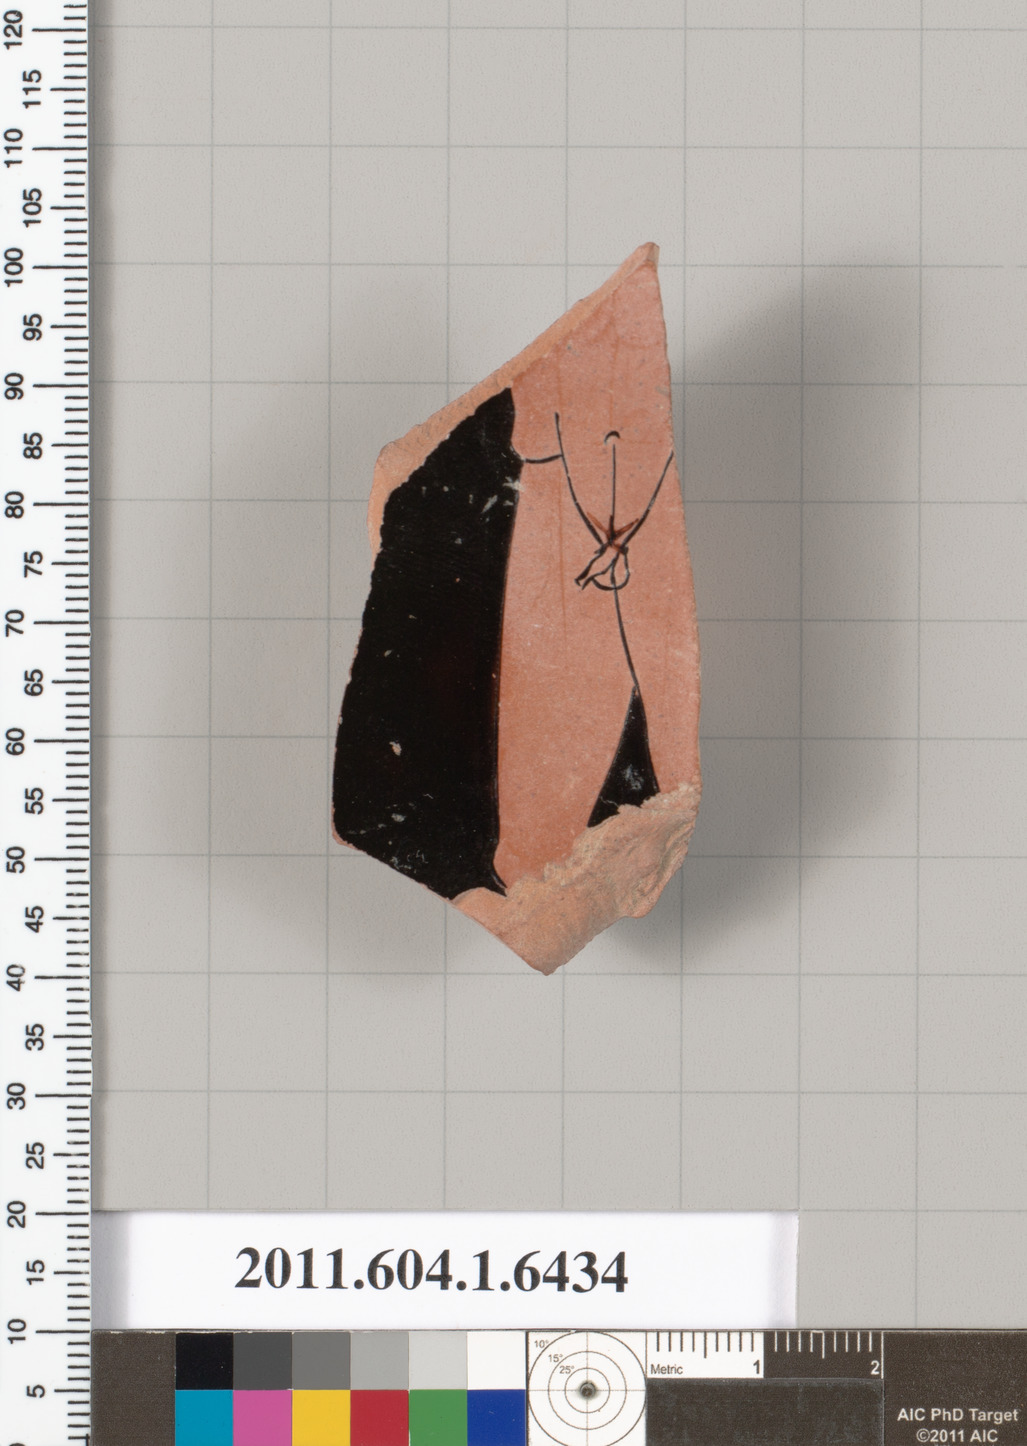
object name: kylix fragment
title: Terracotta fragment of a kylix (drinking cup)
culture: greek, attic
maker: antiphonic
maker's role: artist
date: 490-480 BCE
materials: terracotta